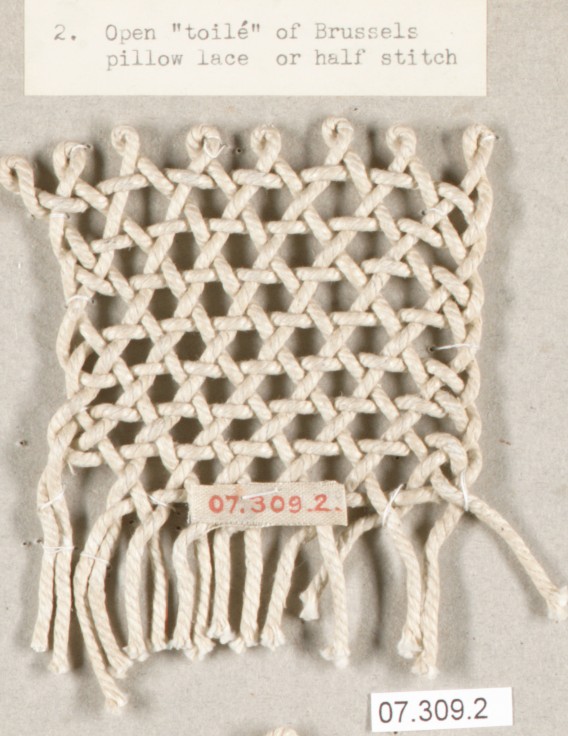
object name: stitch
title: Example of lace stitch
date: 1801-2000